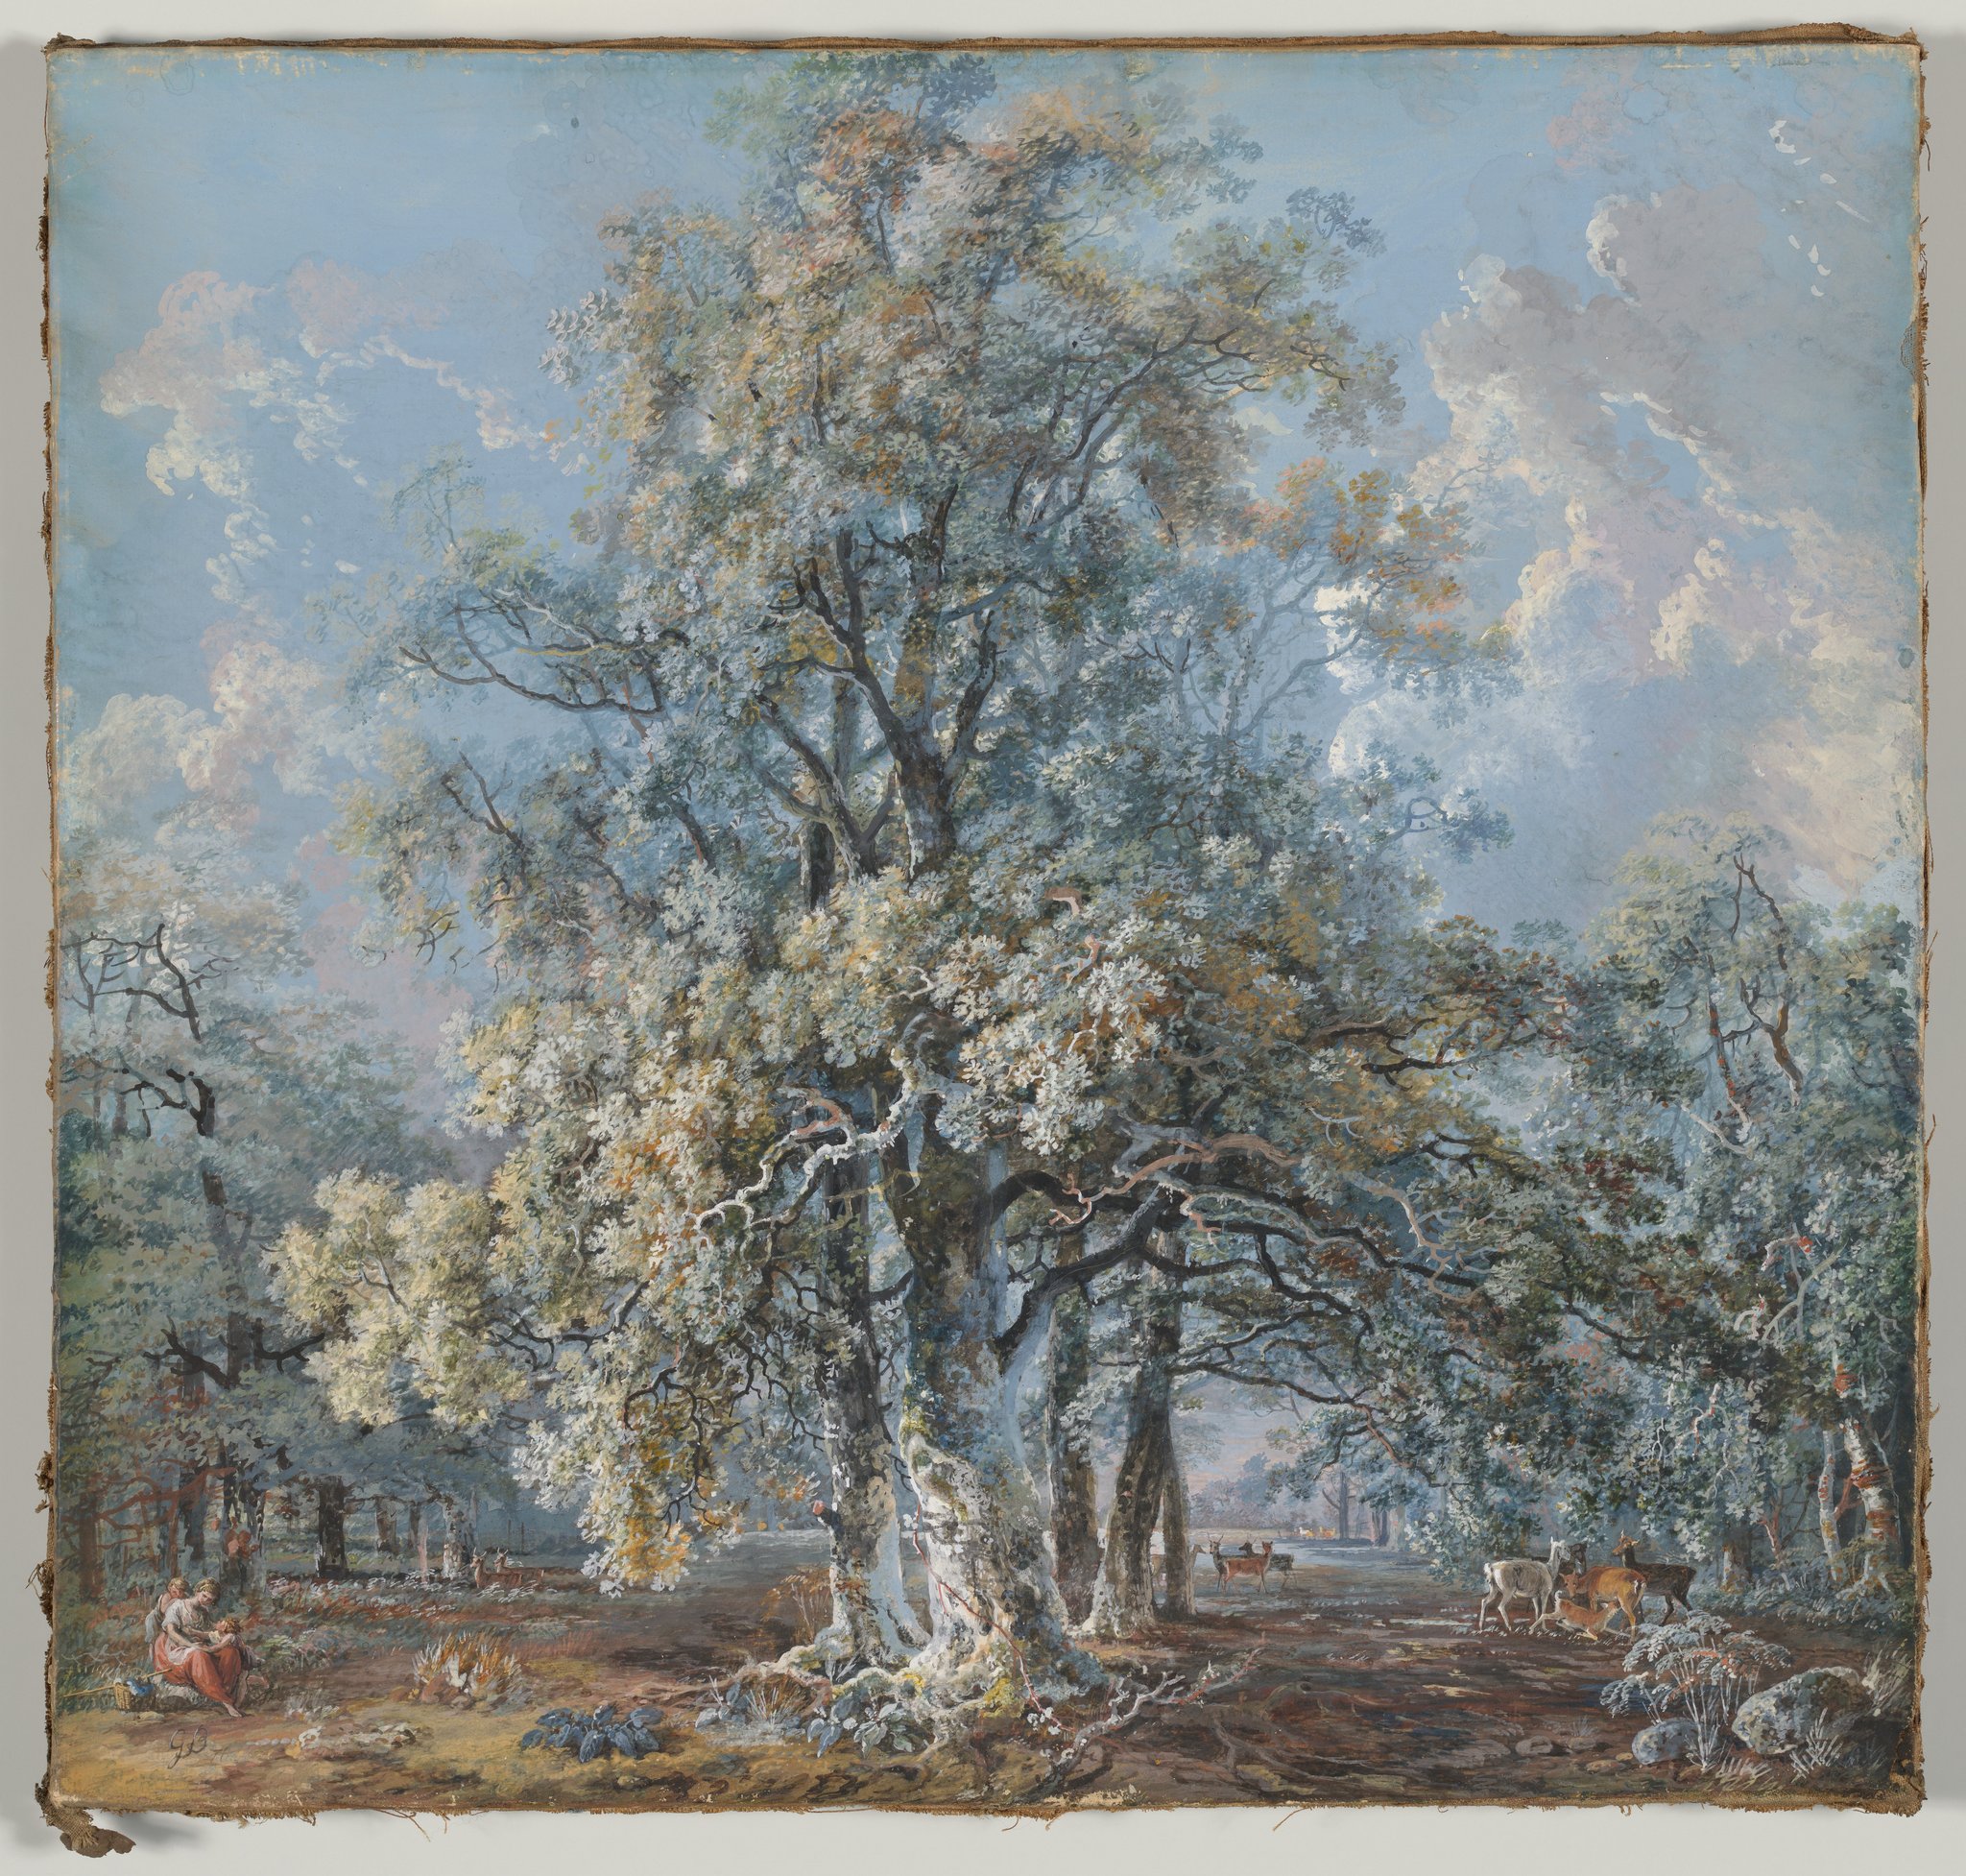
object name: drawing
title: A mother and children resting beneath a large beech tree, deer grazing beyond, possibly in Norbury Park, Surrey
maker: george barret, the elder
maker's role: artist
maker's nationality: irish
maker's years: 1732-1784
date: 1776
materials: gouache, graphite, gum arabic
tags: parks,girls,mothers,deer,trees